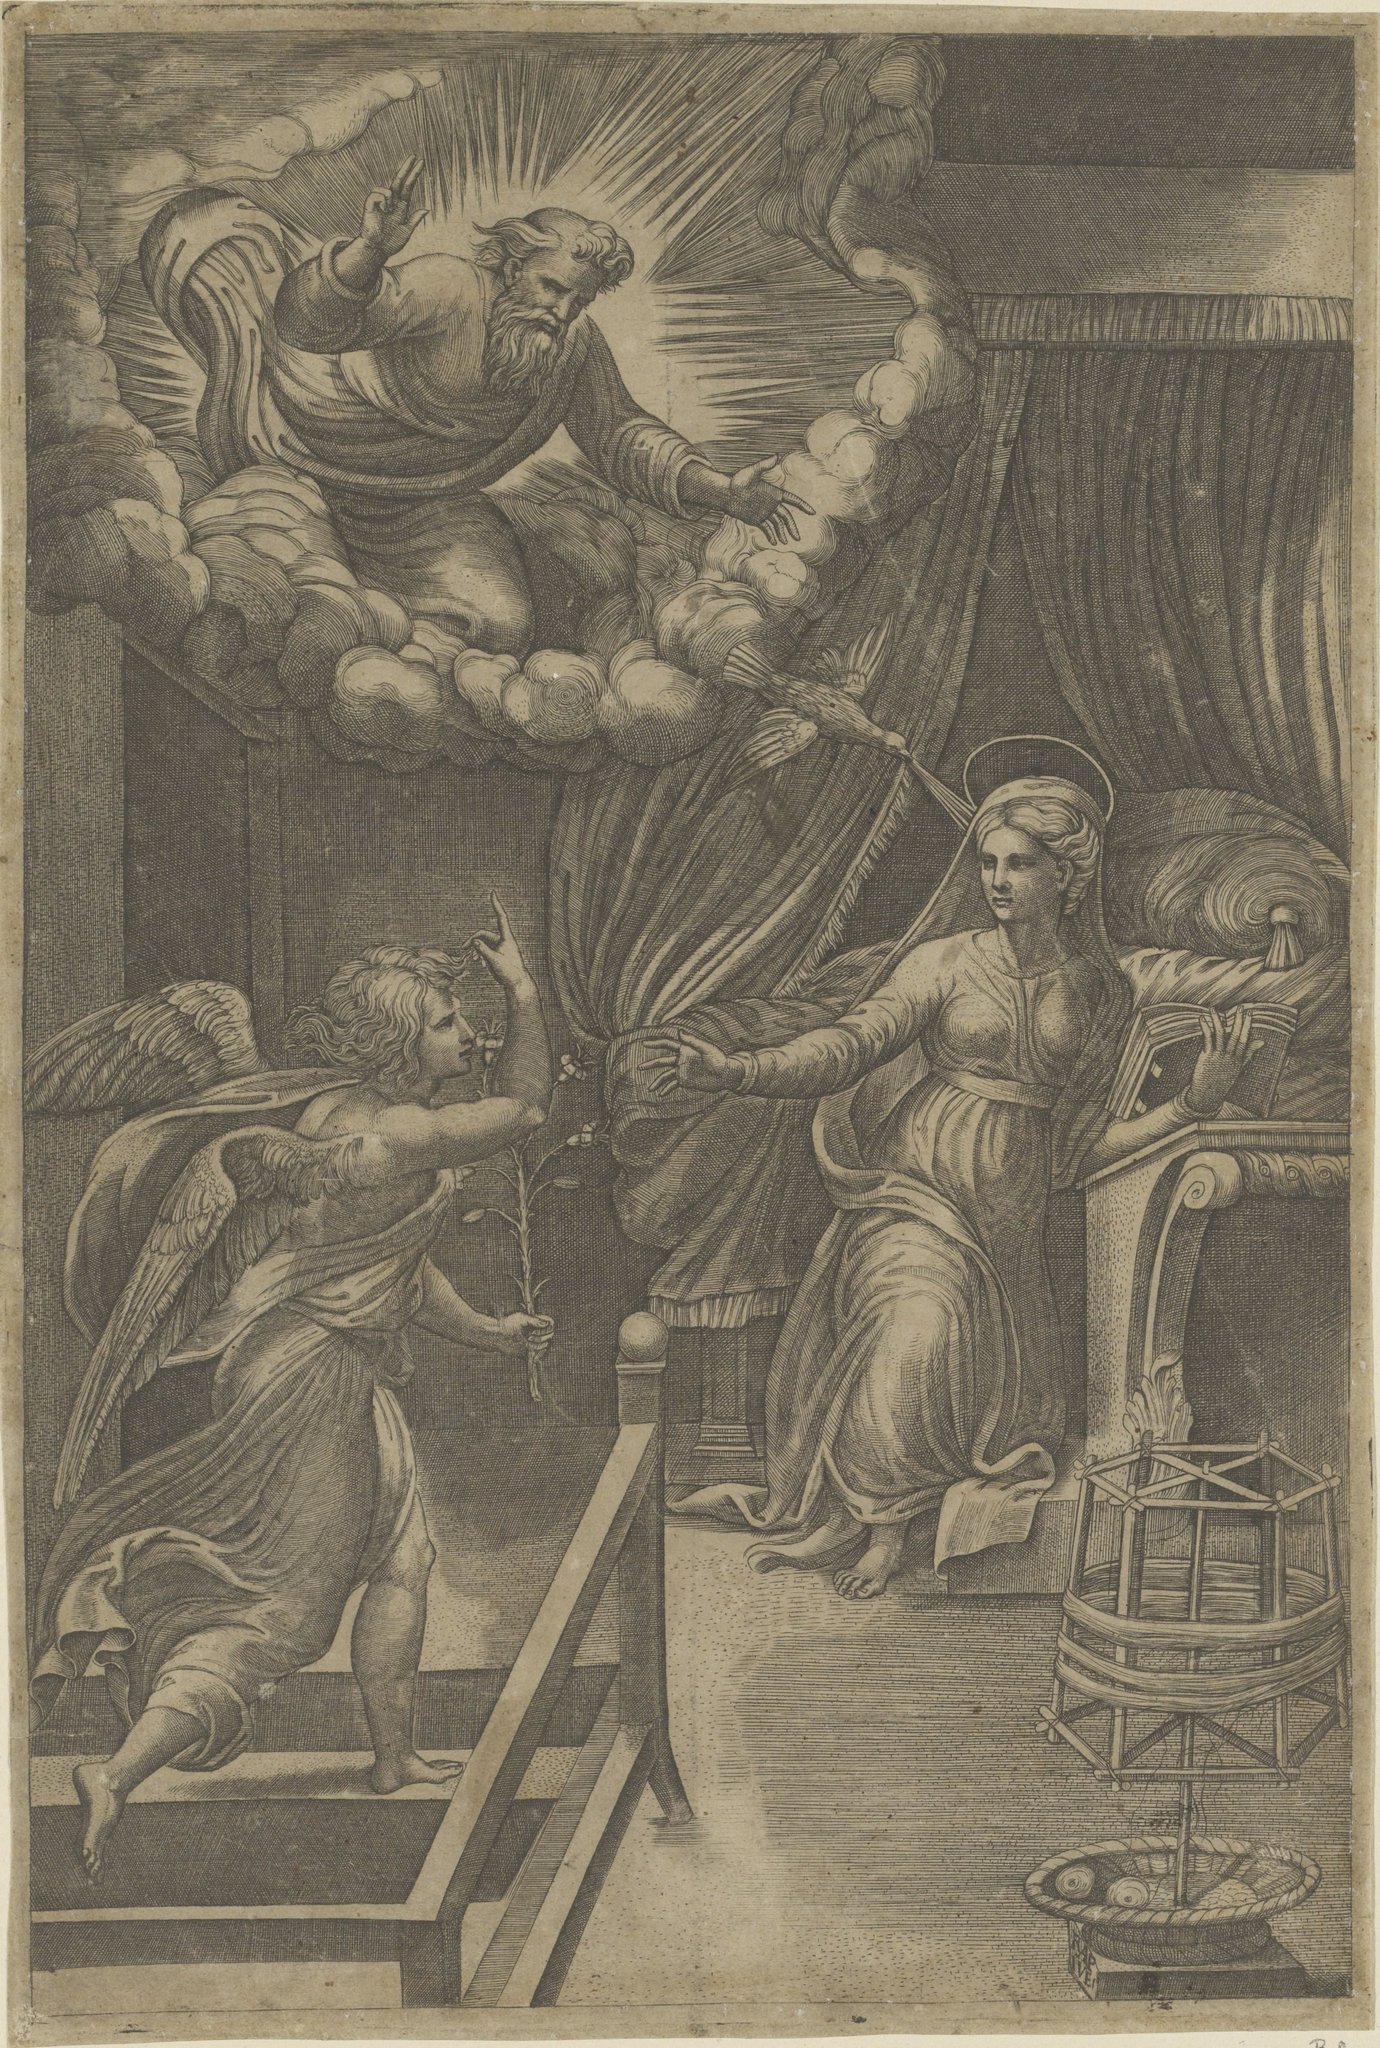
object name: print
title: Annunciatie met God de Vader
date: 1515-1565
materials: paper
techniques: engraving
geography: italy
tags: the annunciation: mary, usually reading, is visited by the angel (sometimes a woman overhears the conversation)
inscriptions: collector's mark: Lugt 240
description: De engel Gabriël kondigt aan Maria aan dat ze zwanger zal worden. Maria zit geknield bij een lezenaar. De Heilige Geest daalt als een duif neer. Ook God de Vader verschijnt in een wolk linksboven.